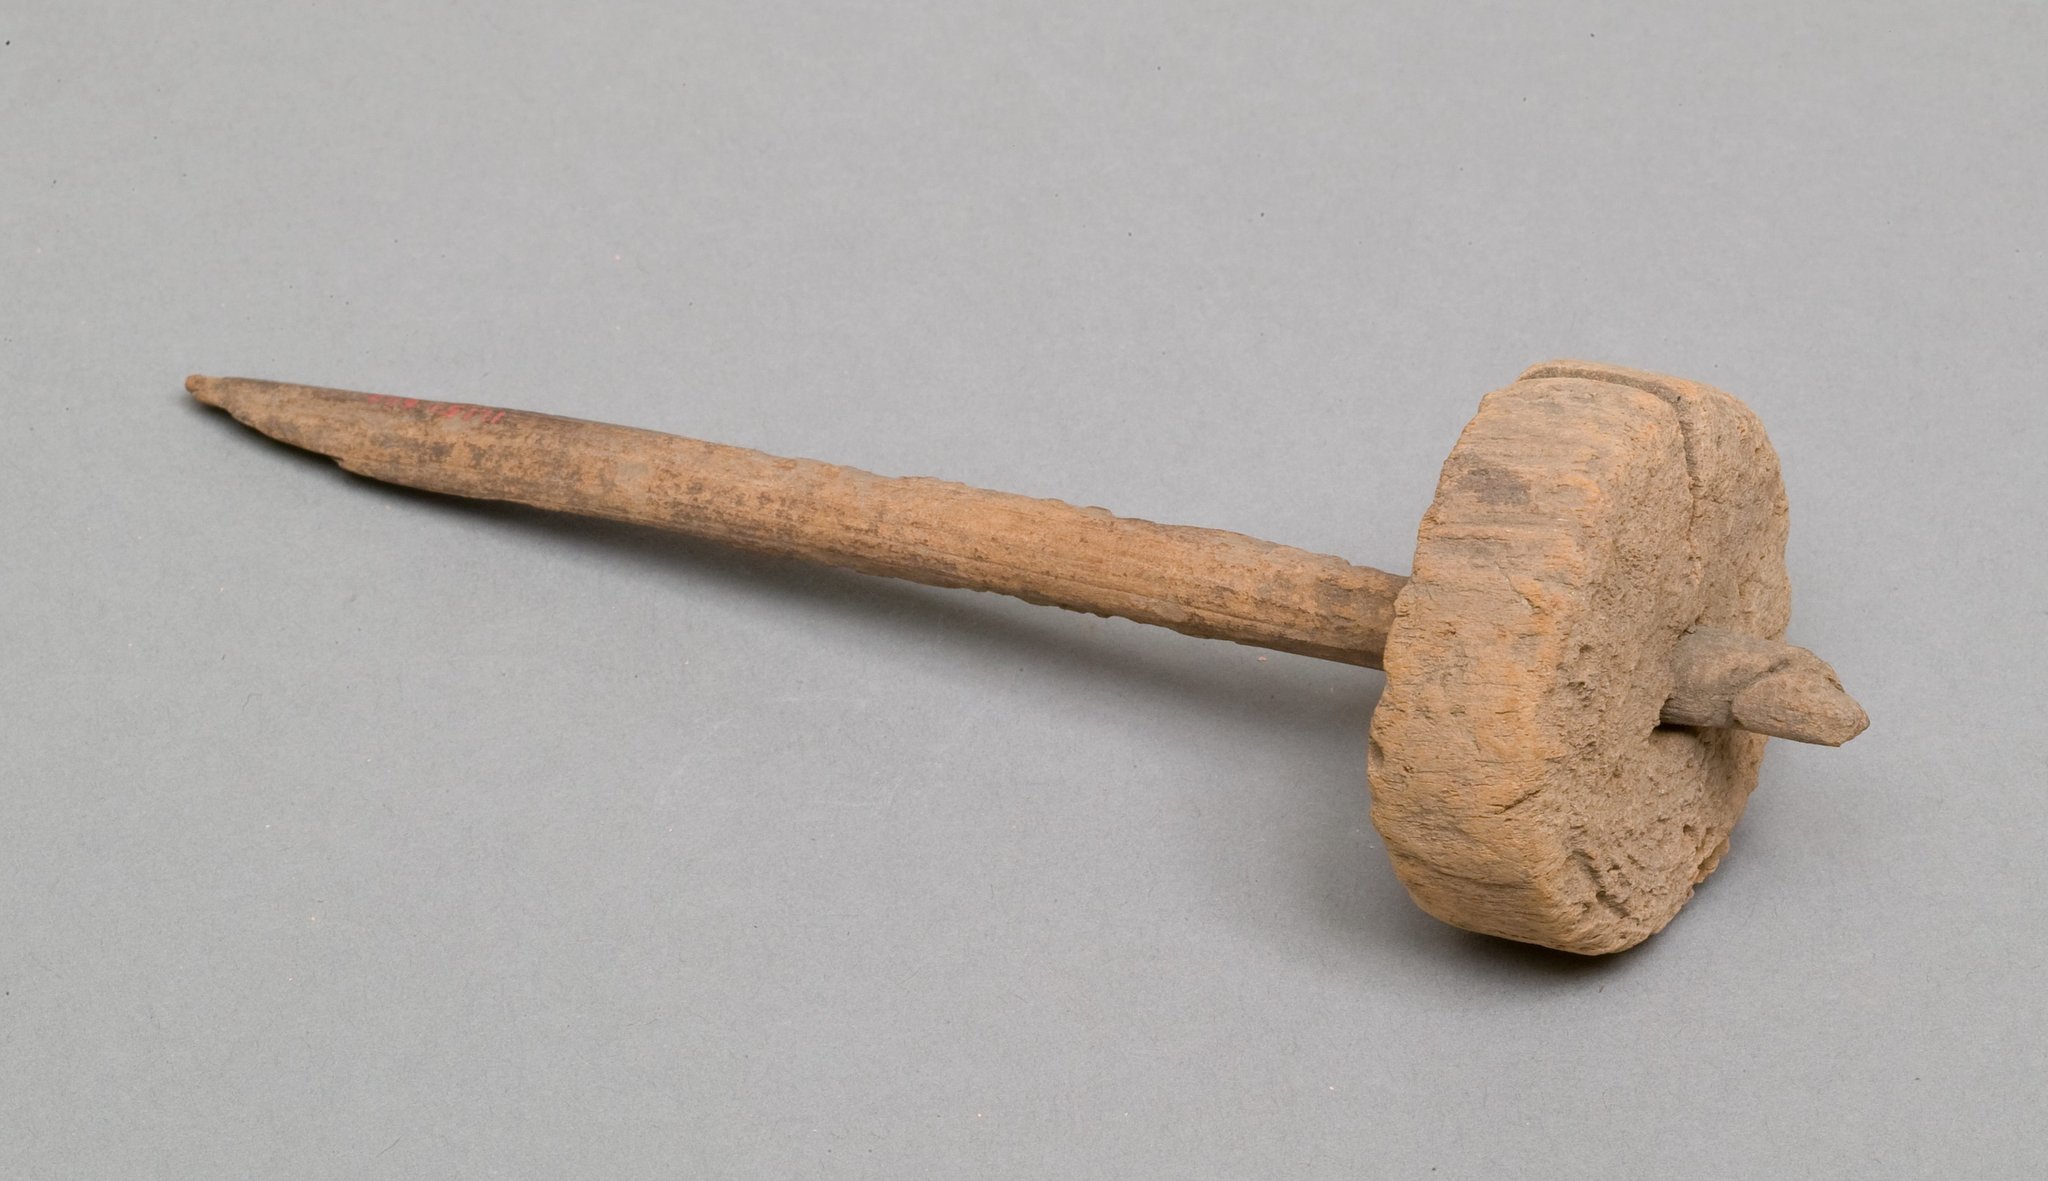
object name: spindle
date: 1295-1070 BCE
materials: wood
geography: egypt